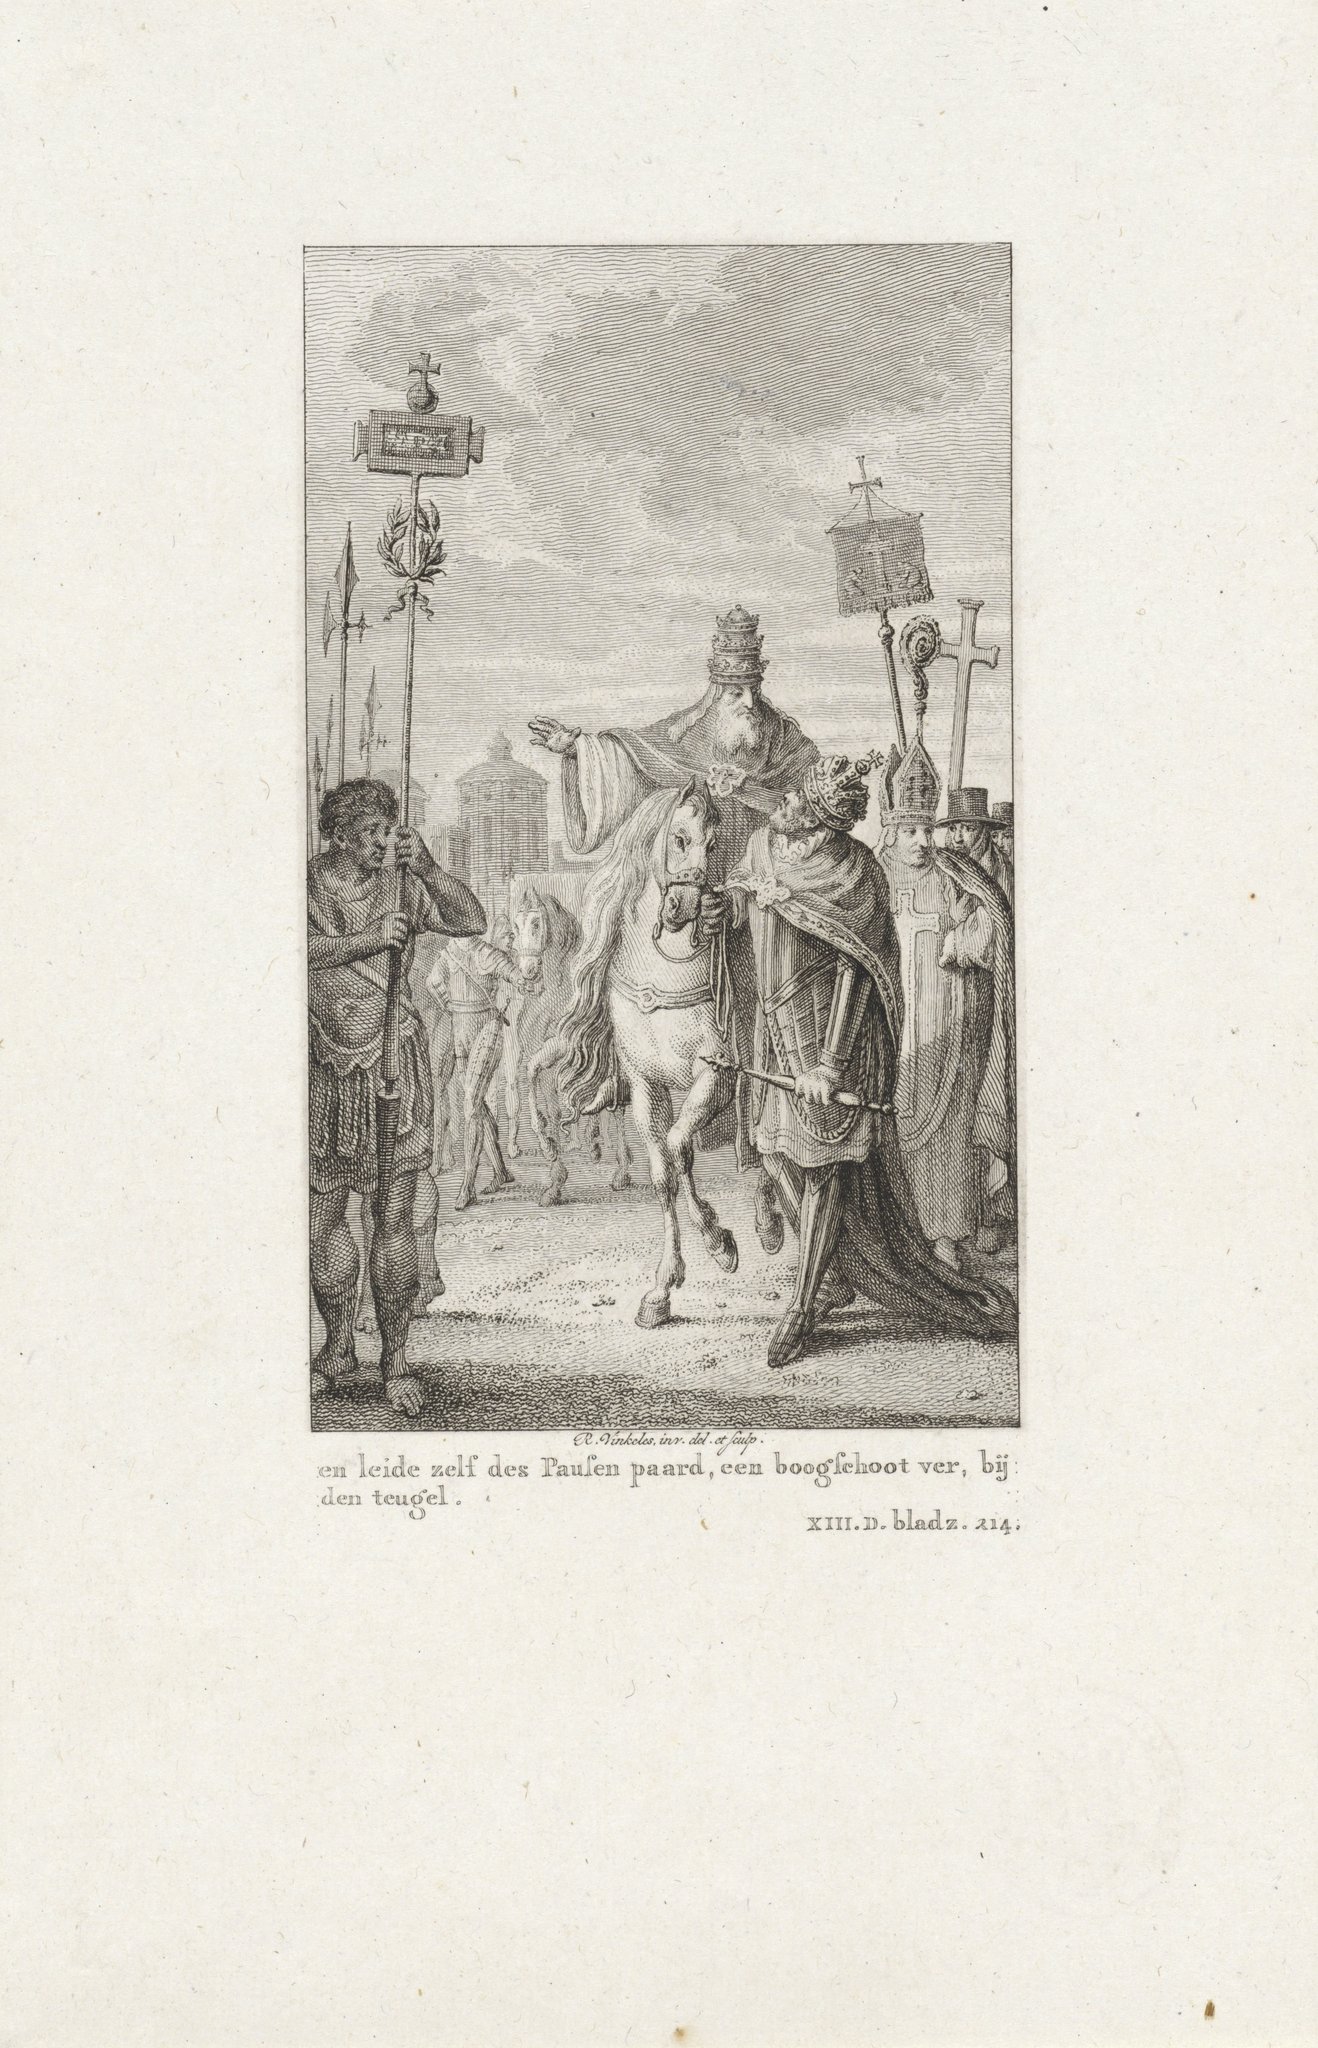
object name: print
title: Keizer Lodewijk II leidt de paus op zijn paard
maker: reinier vinkeles (i)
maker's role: draughtsman, print maker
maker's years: 1741-1816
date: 1806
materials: paper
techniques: engraving, etching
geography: amsterdam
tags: riding a horse, ass, or mule; rider, horseman, ruler, sovereign, procession ~ christian religion, pope, insignia and symbols of sovereignty (crown, diadem, sceptre, orb, seal, standard, cloak, pectoral)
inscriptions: collector's mark: Lugt 240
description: Illustratie in: Hamelsveld, Ysbrand van. Algemeene kerkelijke geschiedenis, der Christenen, deel 13. Haarlem: François Bohn, 1806, p. 214.